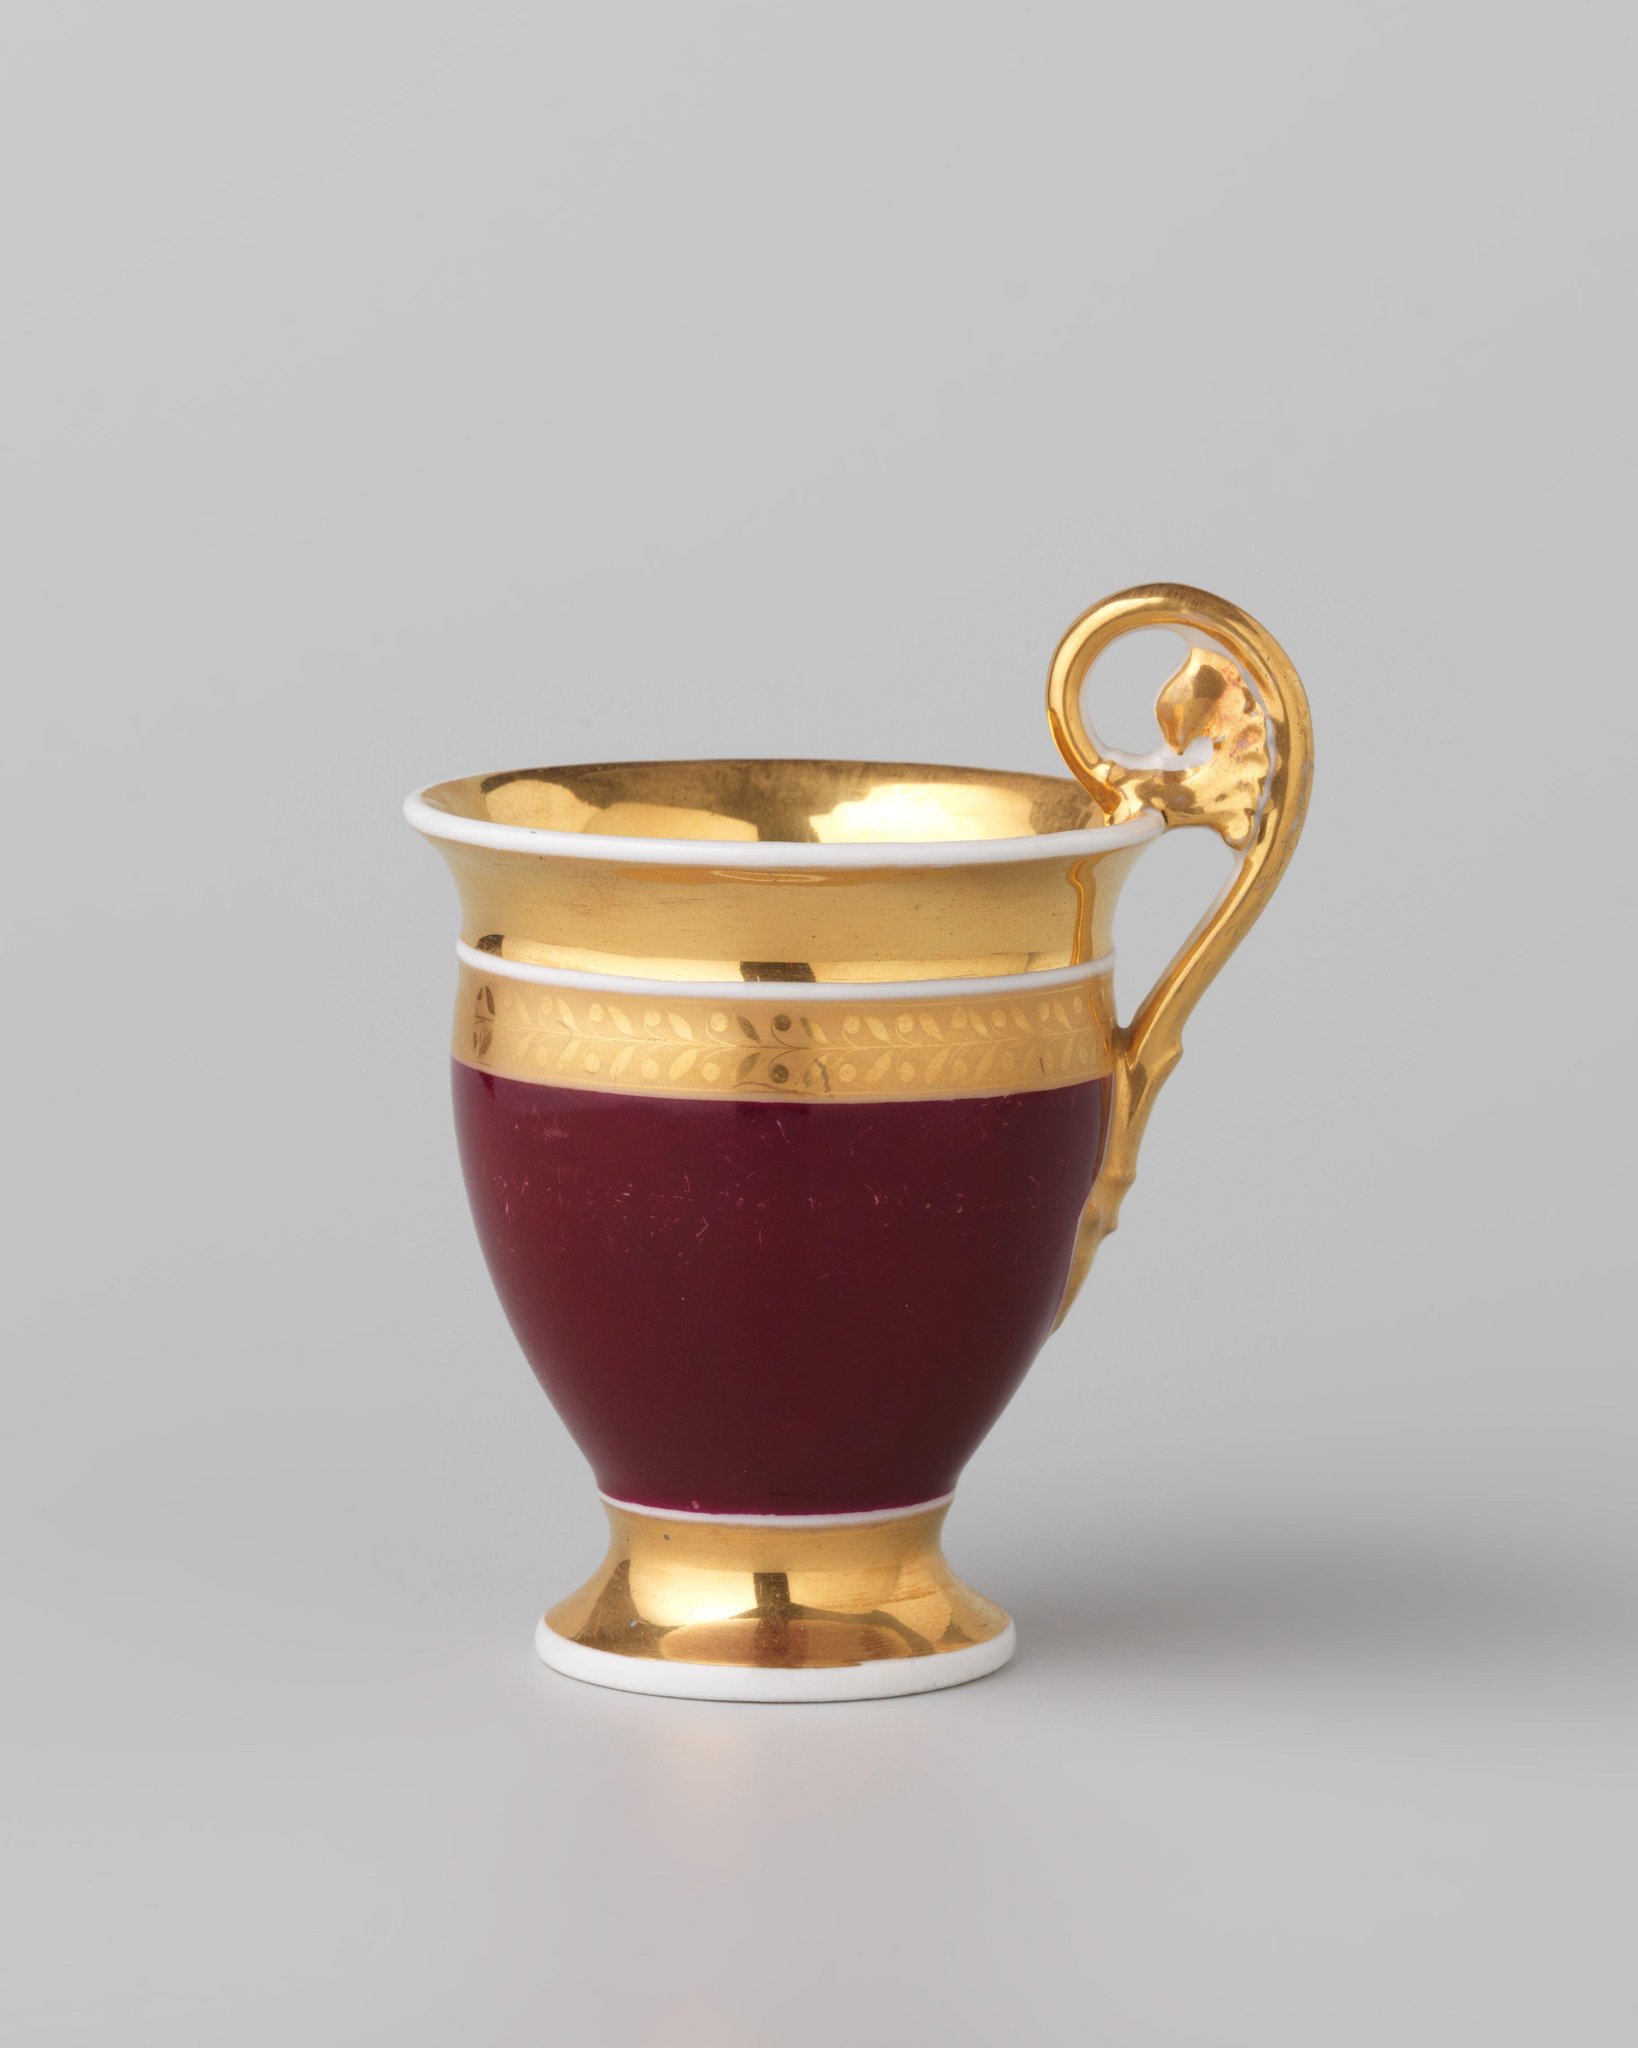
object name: service set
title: Cup with gold borders on a red ground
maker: Anonymous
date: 1800-1824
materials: glaze, gold, paint, porcelain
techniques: firing, forming, gilding, turning, vitrification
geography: france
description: Kop van porselein op spreidende voet en met een hoog, gekruld oor, bedekt op het glazuur met rood en goud. De buitenwand is bedekt met rood en de voet, rand, oor en een deel van de binnenwand met goud. Op de buitenrand een bloemrank in één van de gouden banden. Empire.